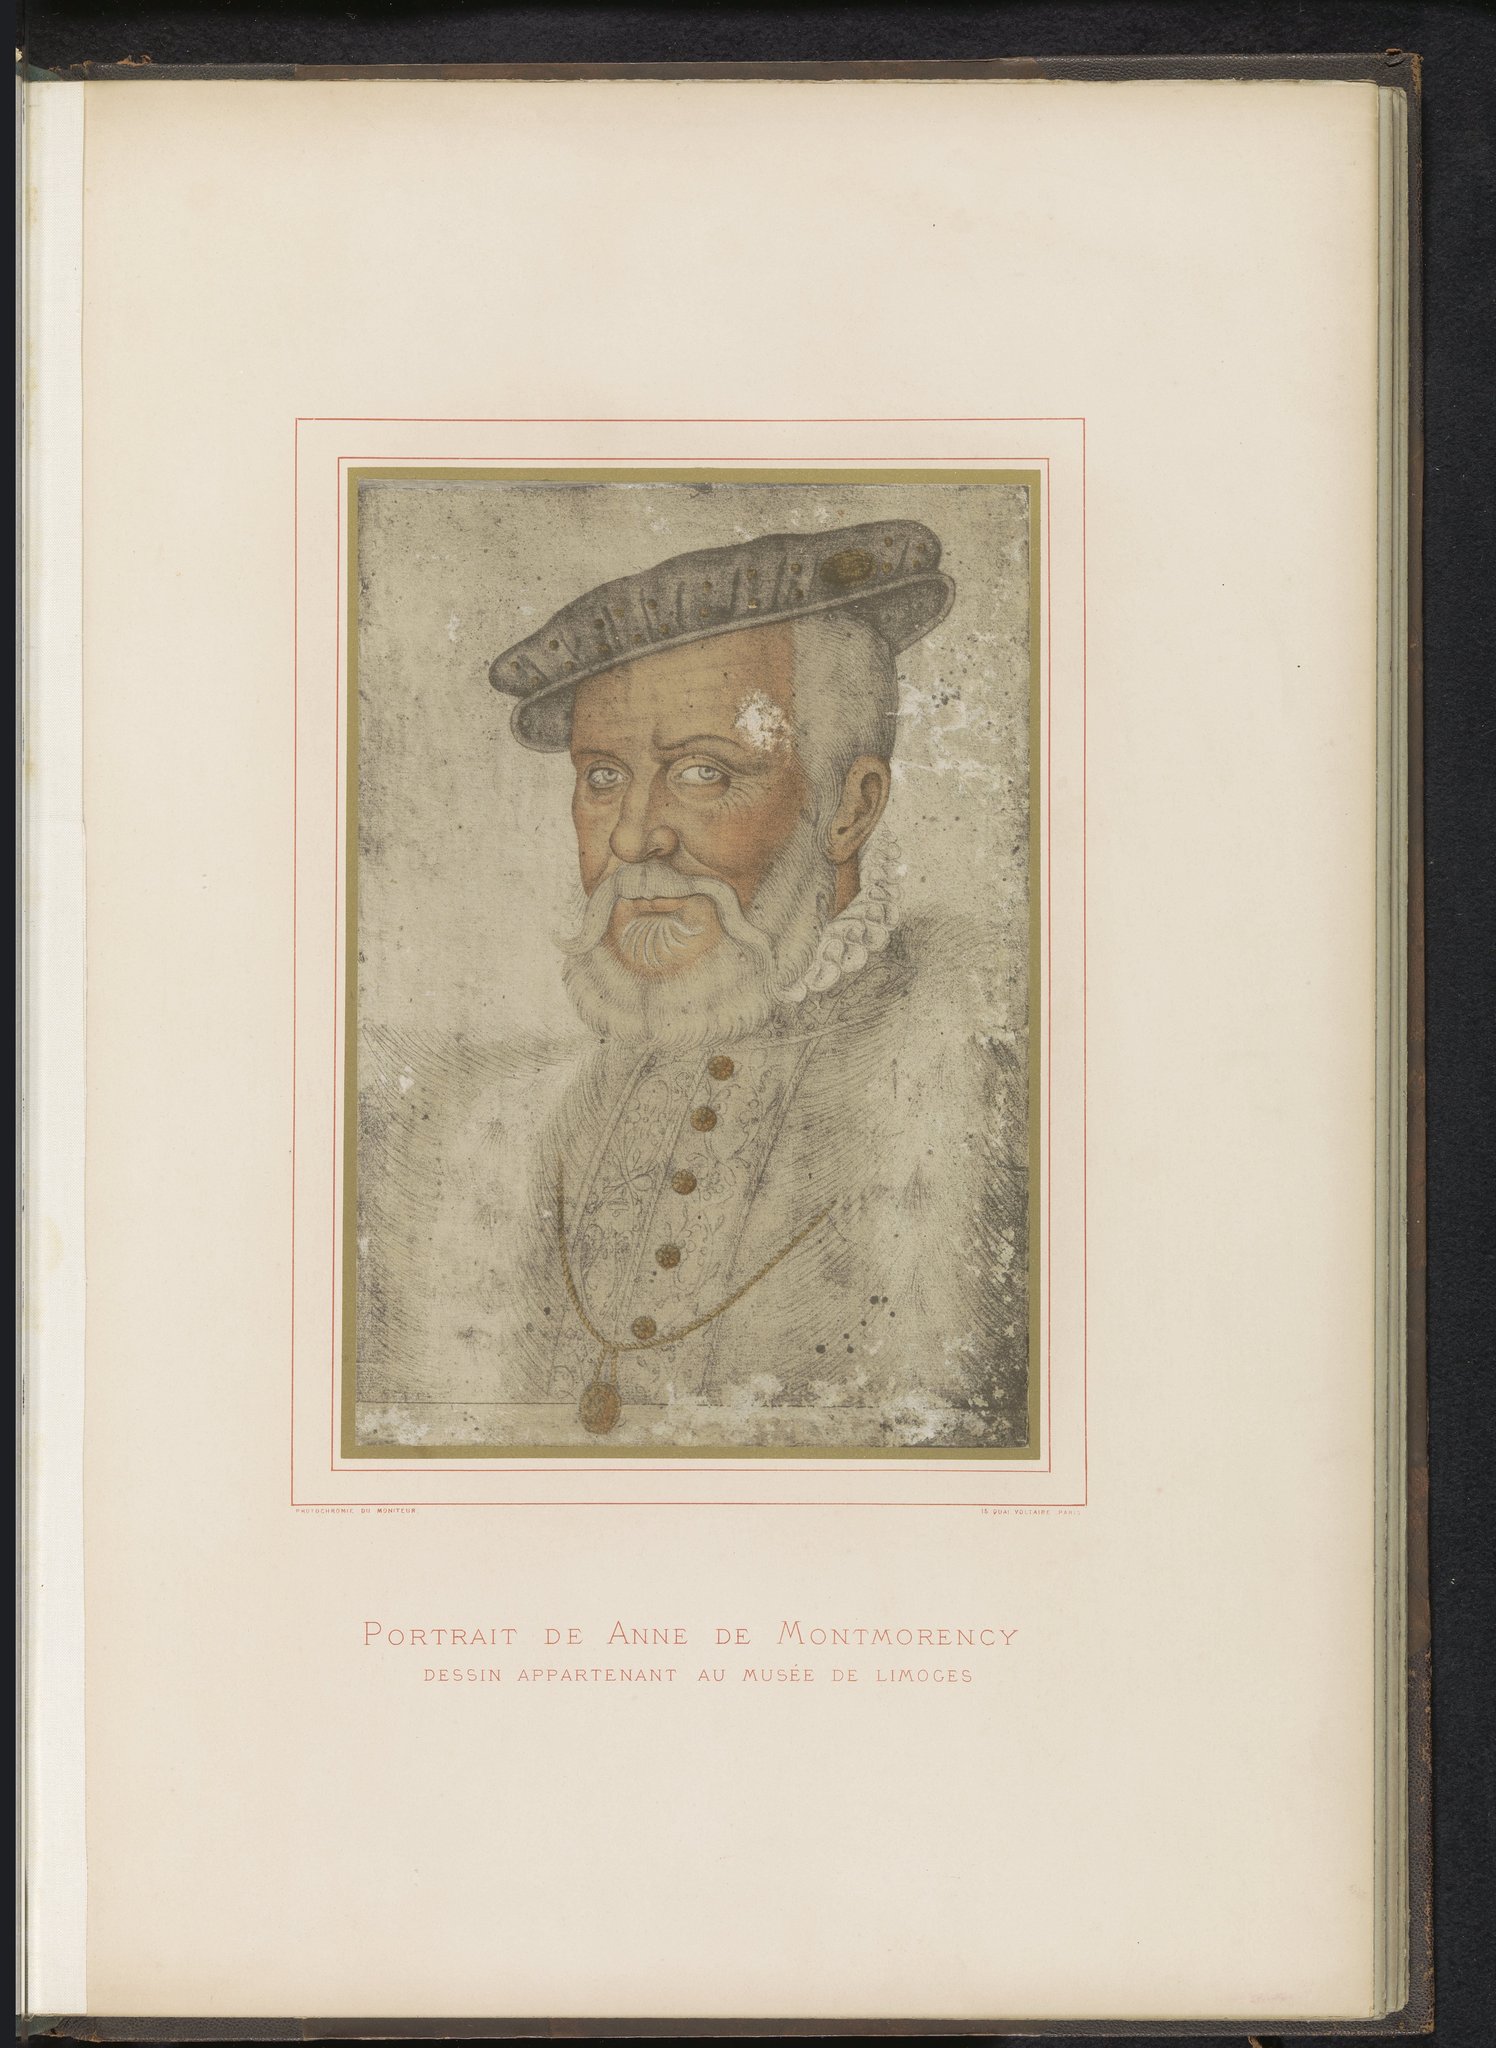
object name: reproduction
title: Musée National du Louvre Galerie d'Apollon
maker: léon vidal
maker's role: fotograaf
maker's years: 1833-1906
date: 1876-1883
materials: paper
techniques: photograph, hand coloring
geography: paris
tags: chantilly, paris, commander-in-chief, general, marshal